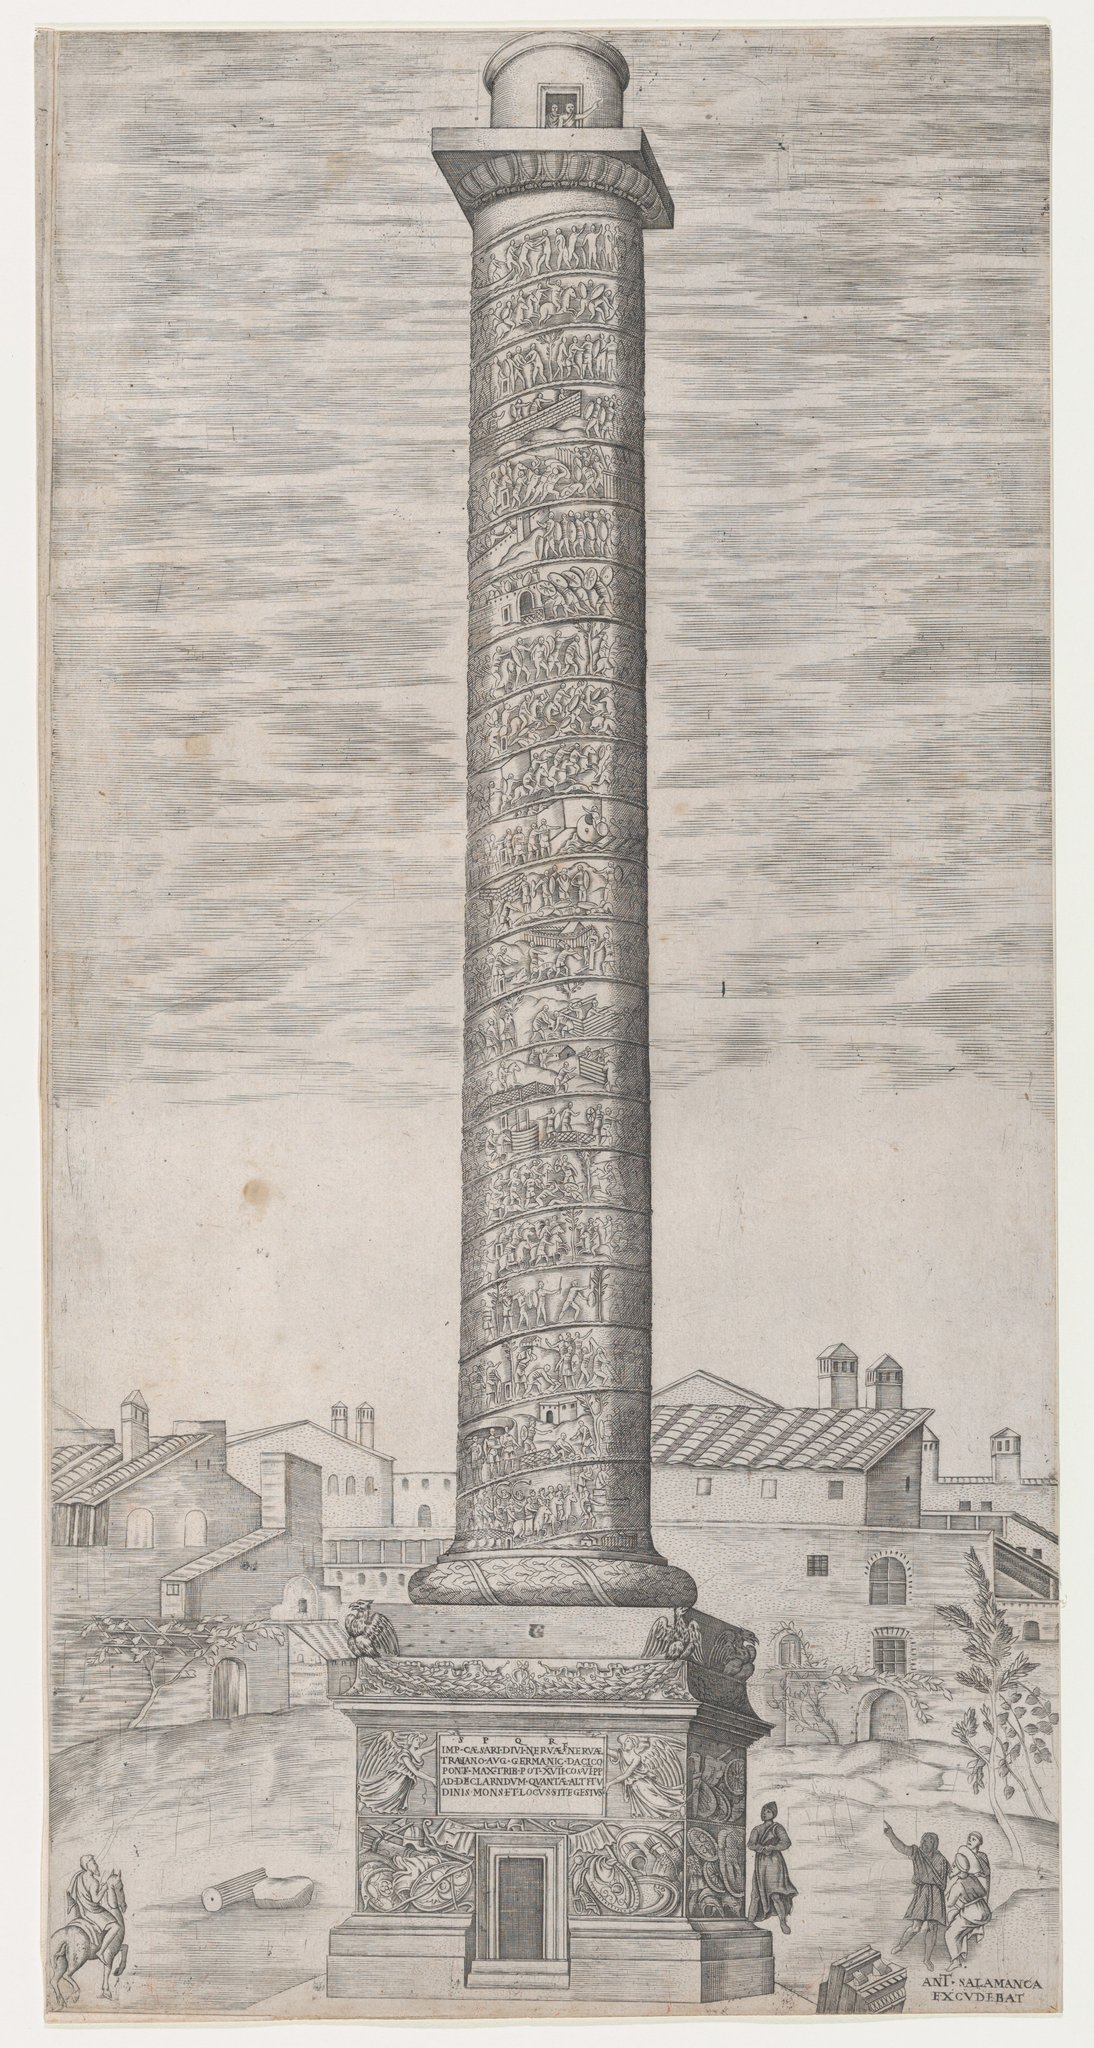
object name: print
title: Column of Trajan, from "Speculum Romanae Magnificentiae"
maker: Anonymous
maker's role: artist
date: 1501-1600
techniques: engraving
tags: columns,rome